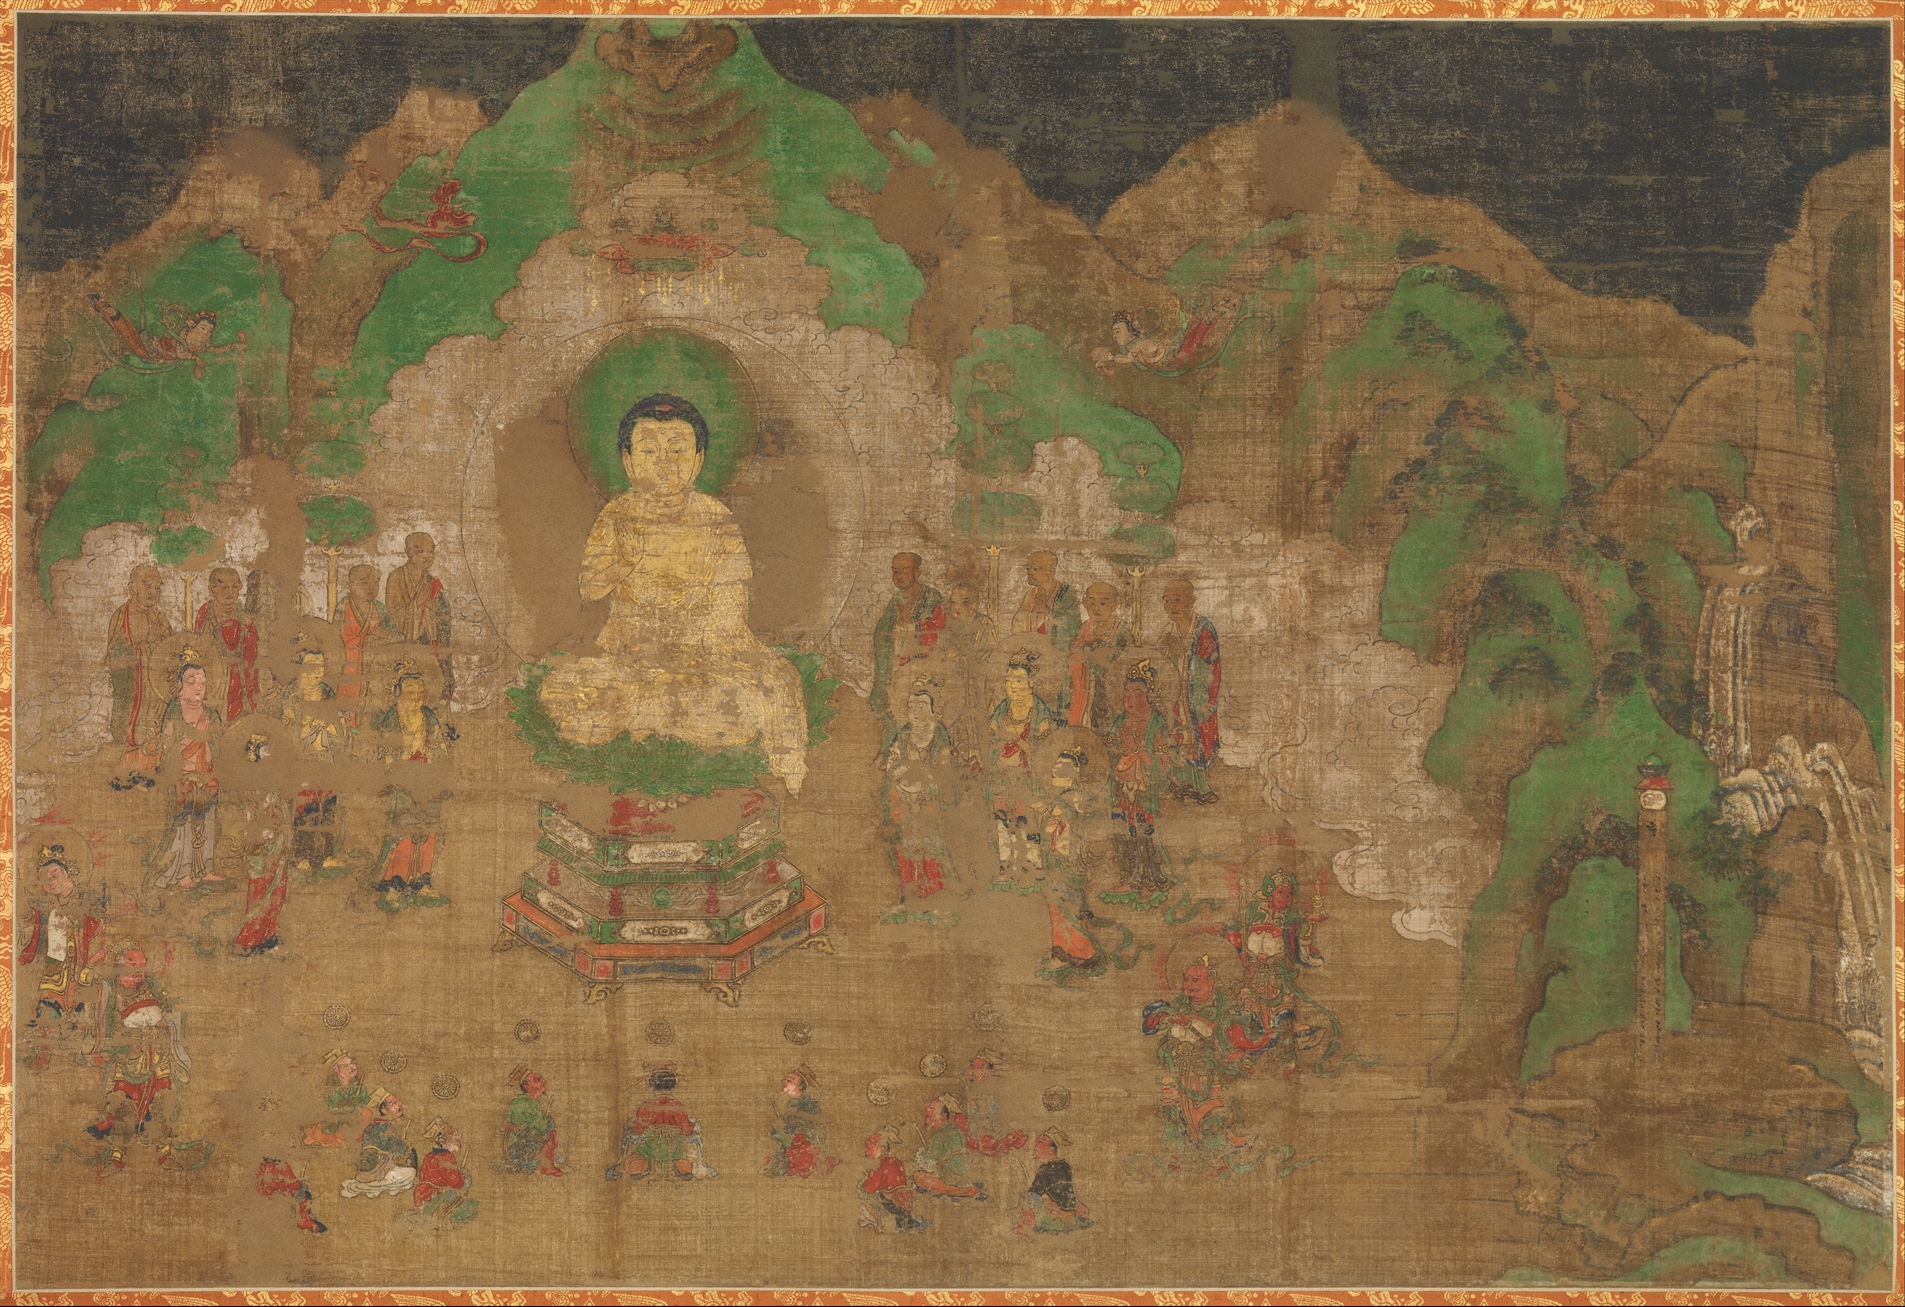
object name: hanging scroll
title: Scene from the Life of the Buddha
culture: japanese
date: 1401-1433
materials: gold, ink, silk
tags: men,buddhism,bodhisattvas,buddha